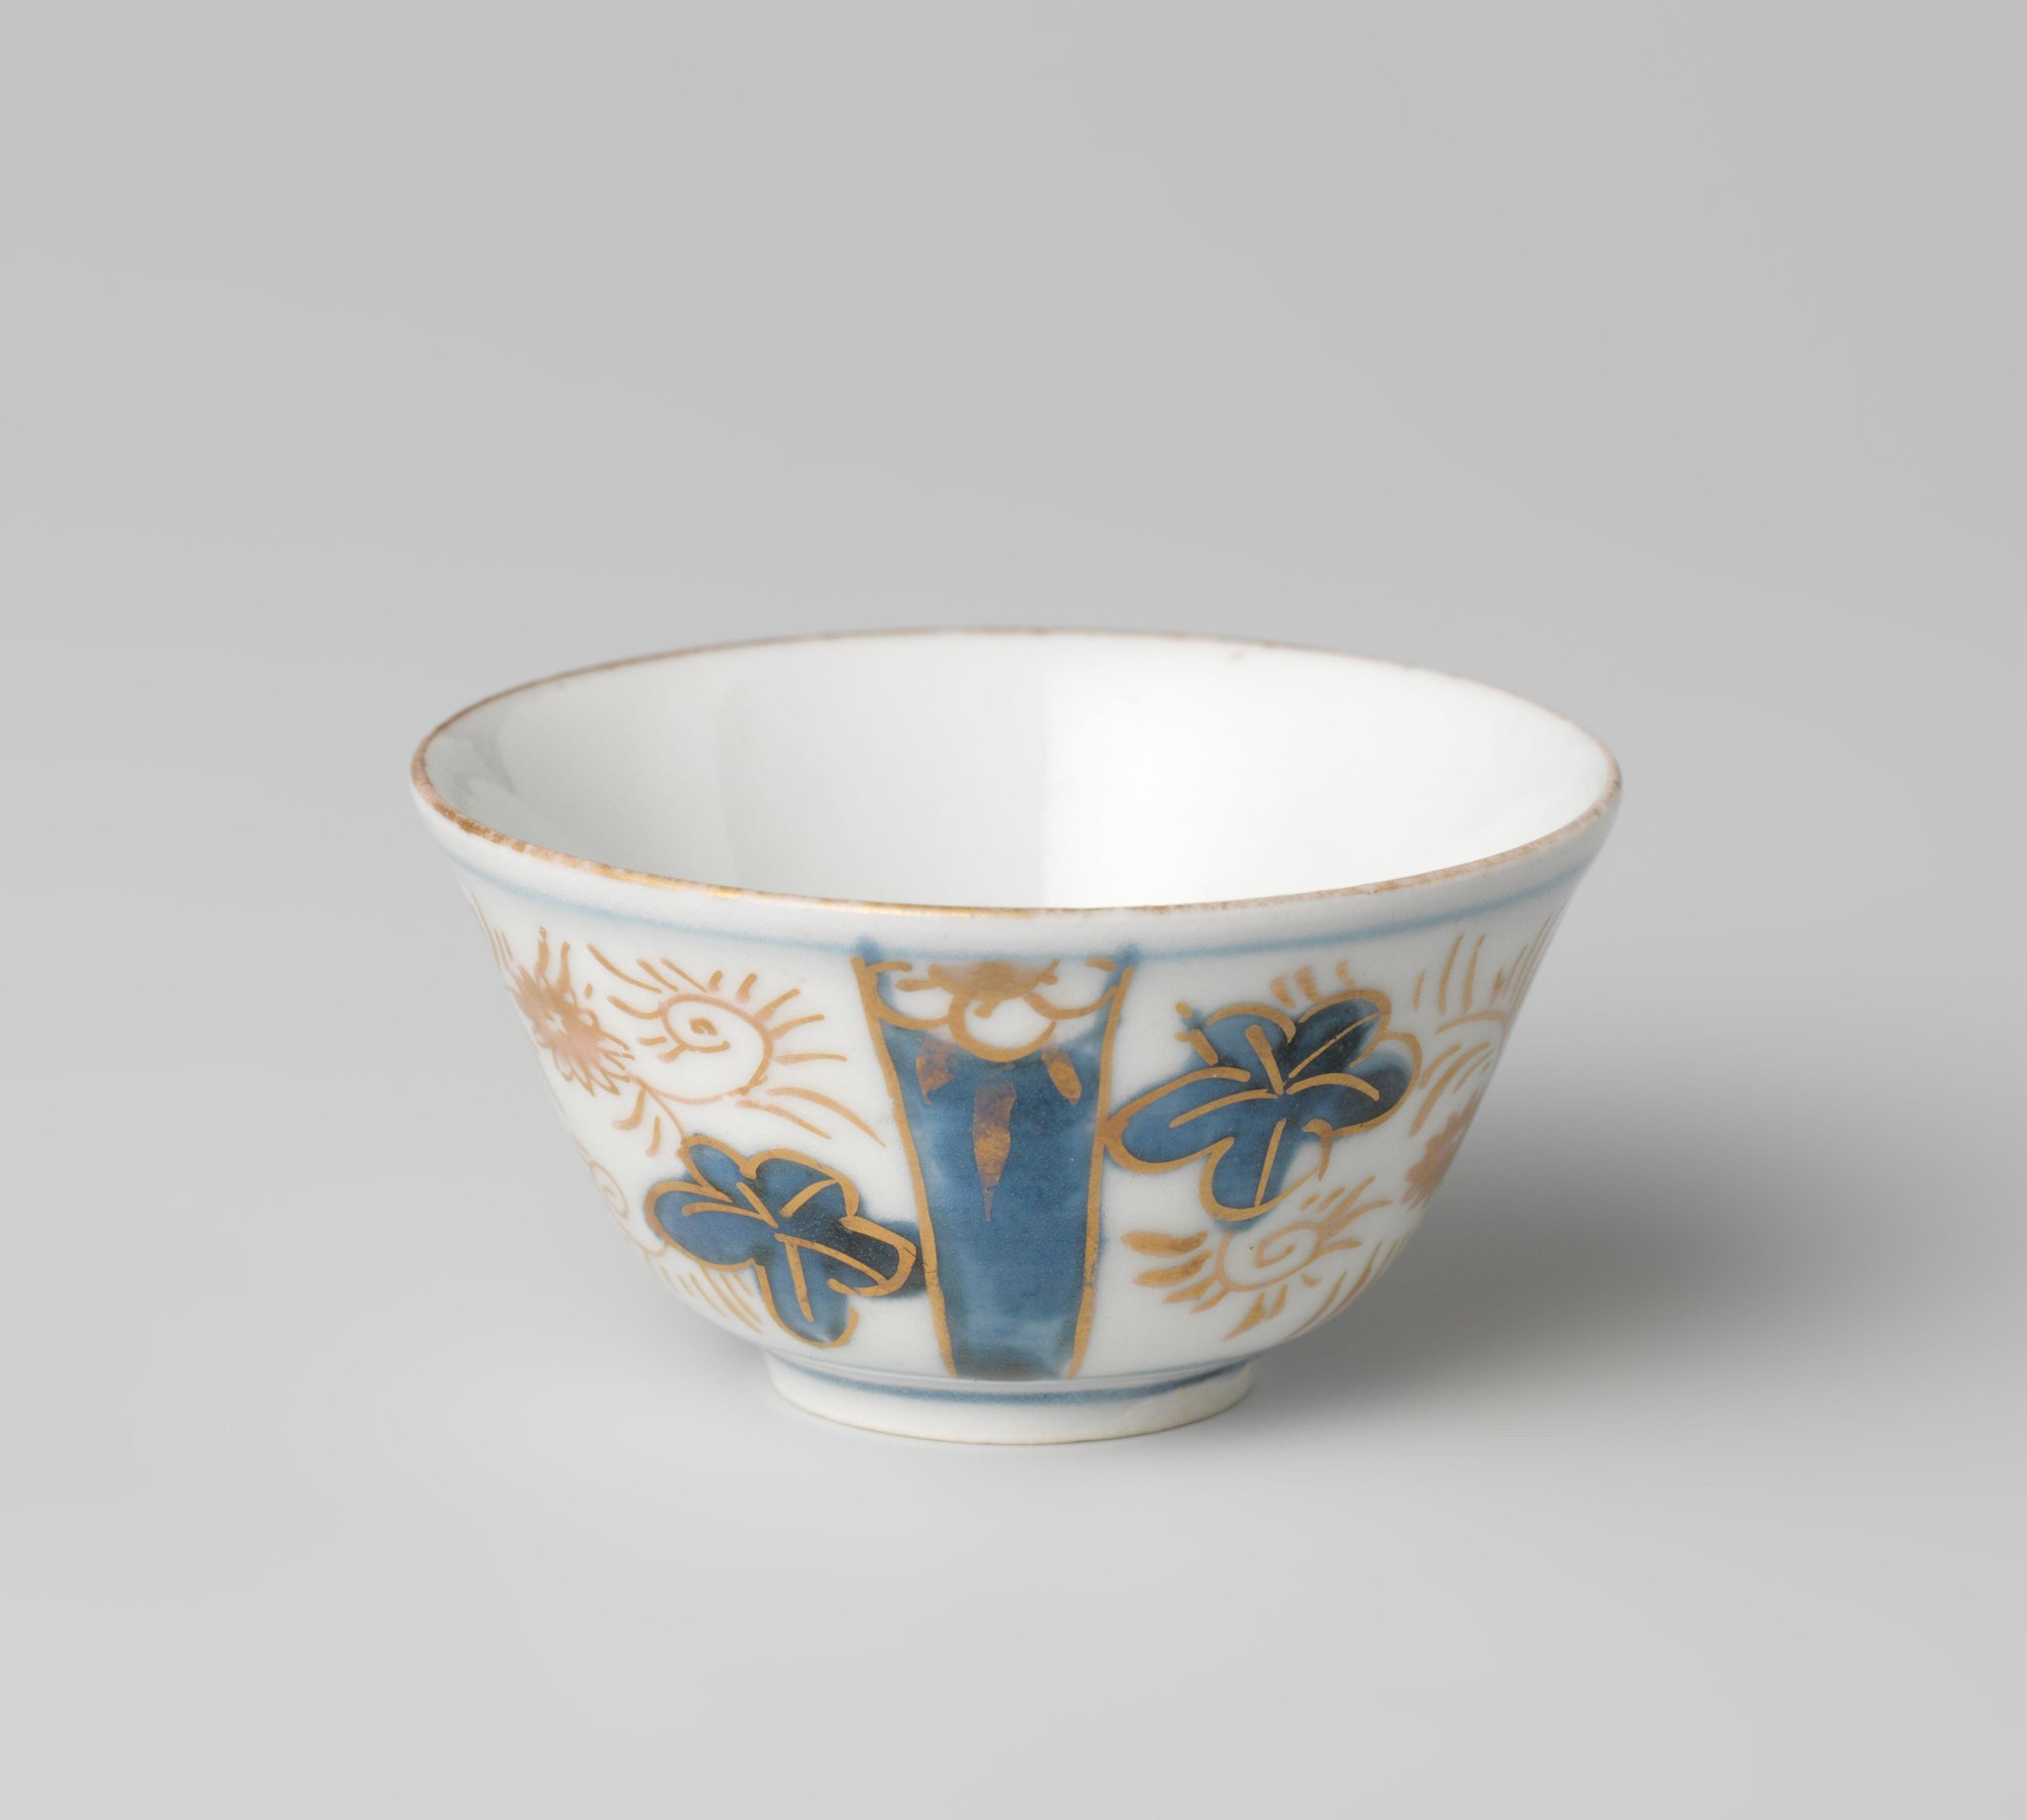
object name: cup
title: Bell-shaped cup with a flower basket and floral scrolls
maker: Anonymous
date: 1775-1799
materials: cobalt, glaze, gold, paint, porcelain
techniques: firing, gilding, turning, vitrification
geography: japan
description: Klokvormige kop van porselein, beschilderd in onderglazuur blauw en op het glazuur goud. Op de bodem in een medaillon een bloempot. De wand is verdeeld in drie waaiervormige vakken gescheiden door een brede streep met een bloem. In de vakken bloemranken. Een barst in de kop. Imari.